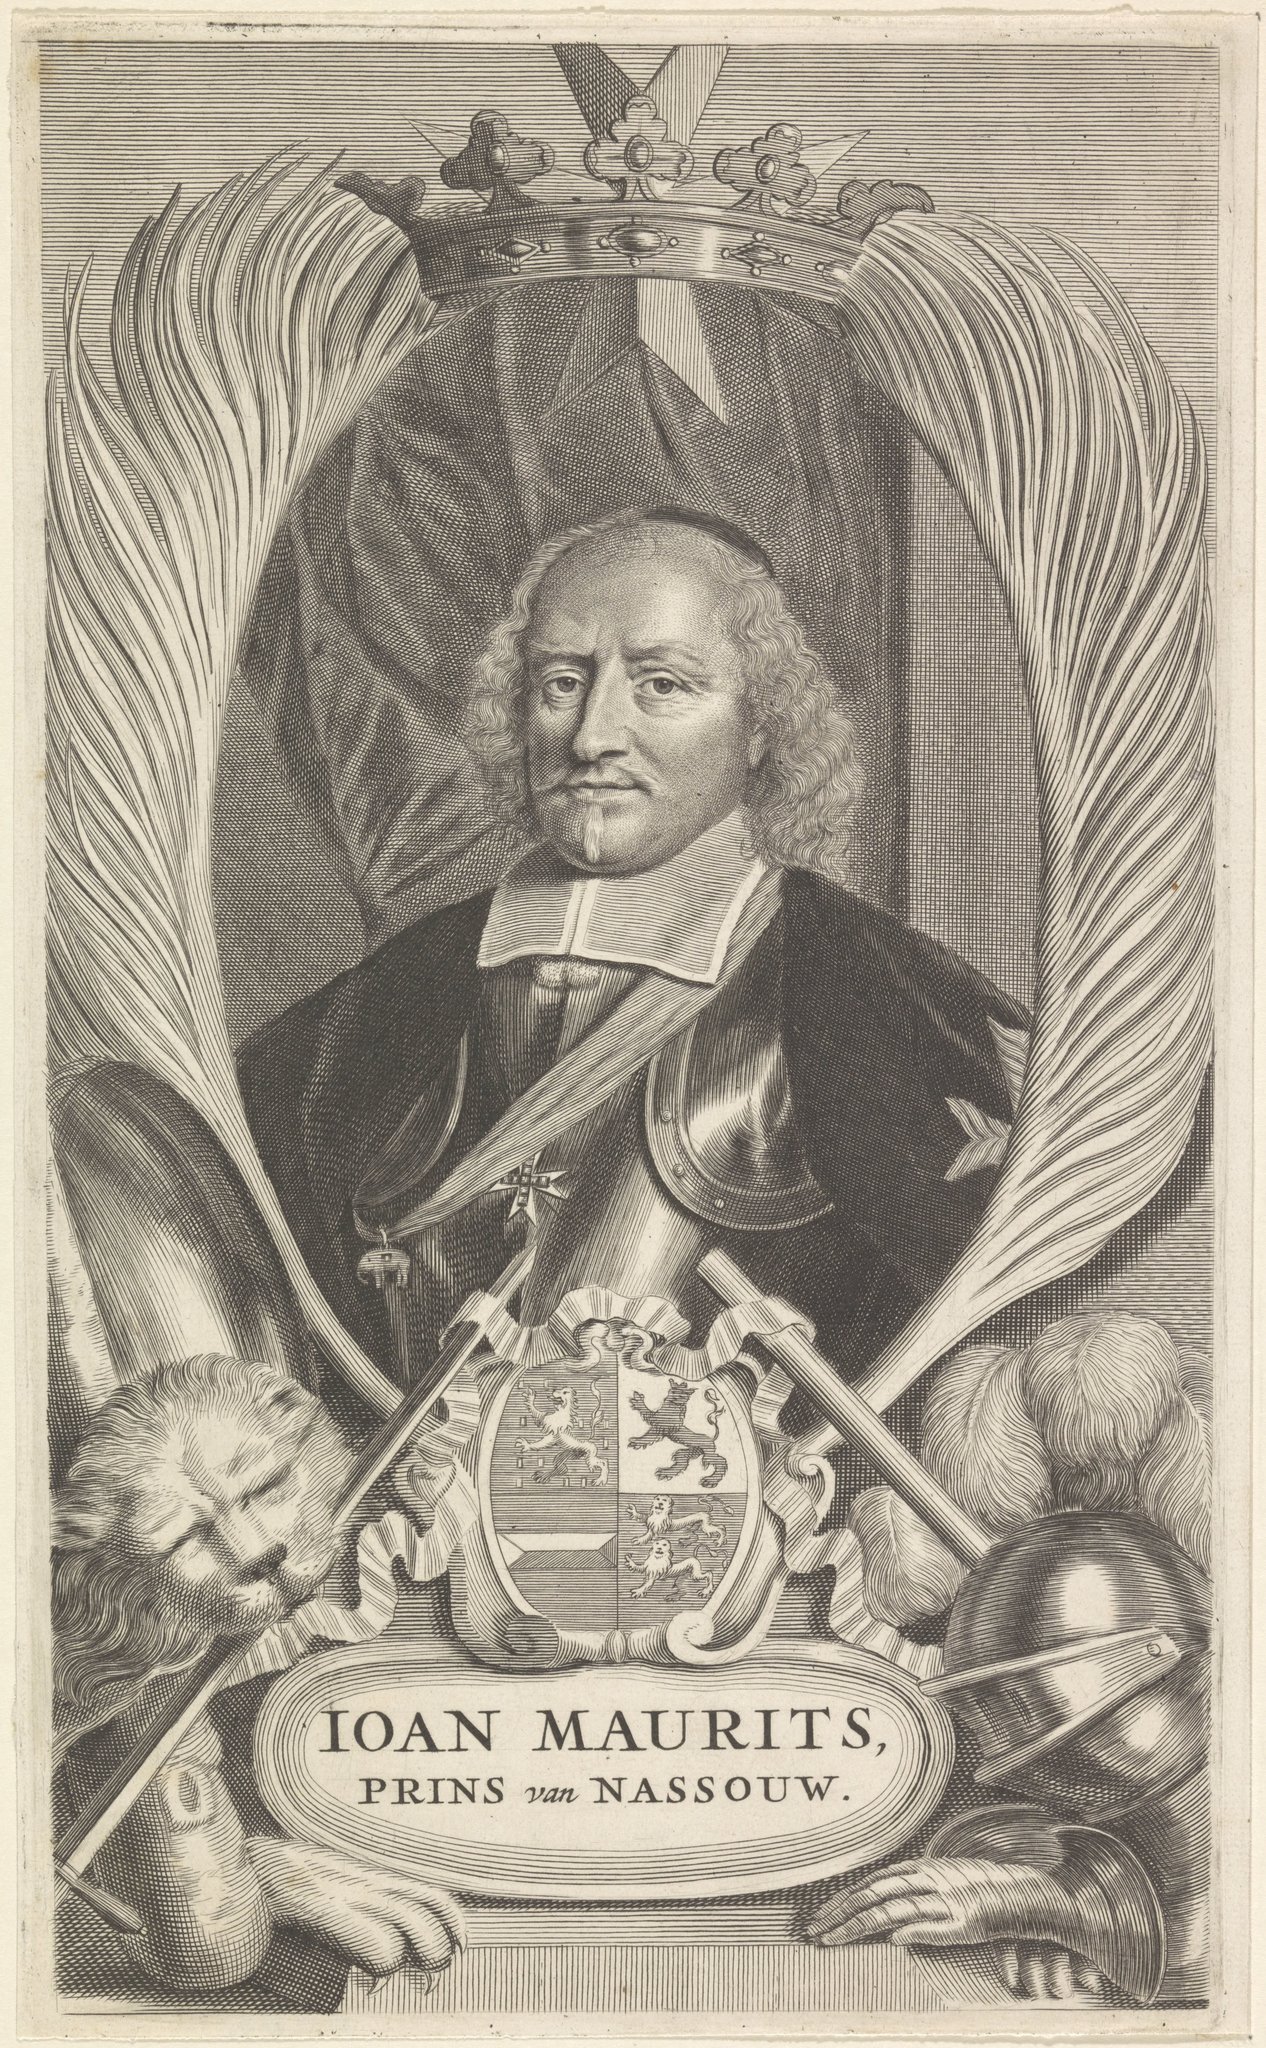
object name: print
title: Portret van Johan Maurits, graaf van Nassau-Siegen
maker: Anonymous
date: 1625-1699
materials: paper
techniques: engraving, etching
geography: low countries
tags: earl, johan maurits graaf van nassau-siegen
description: Portret van Johan Maurits in een ovaal van palmtakken. Daar omheen een aantal allegorische objecten, waaronder een helm en een commandostaf. Midden boven een kroon. Midden onder zijn wapen. In een kader zijn naam en titel.